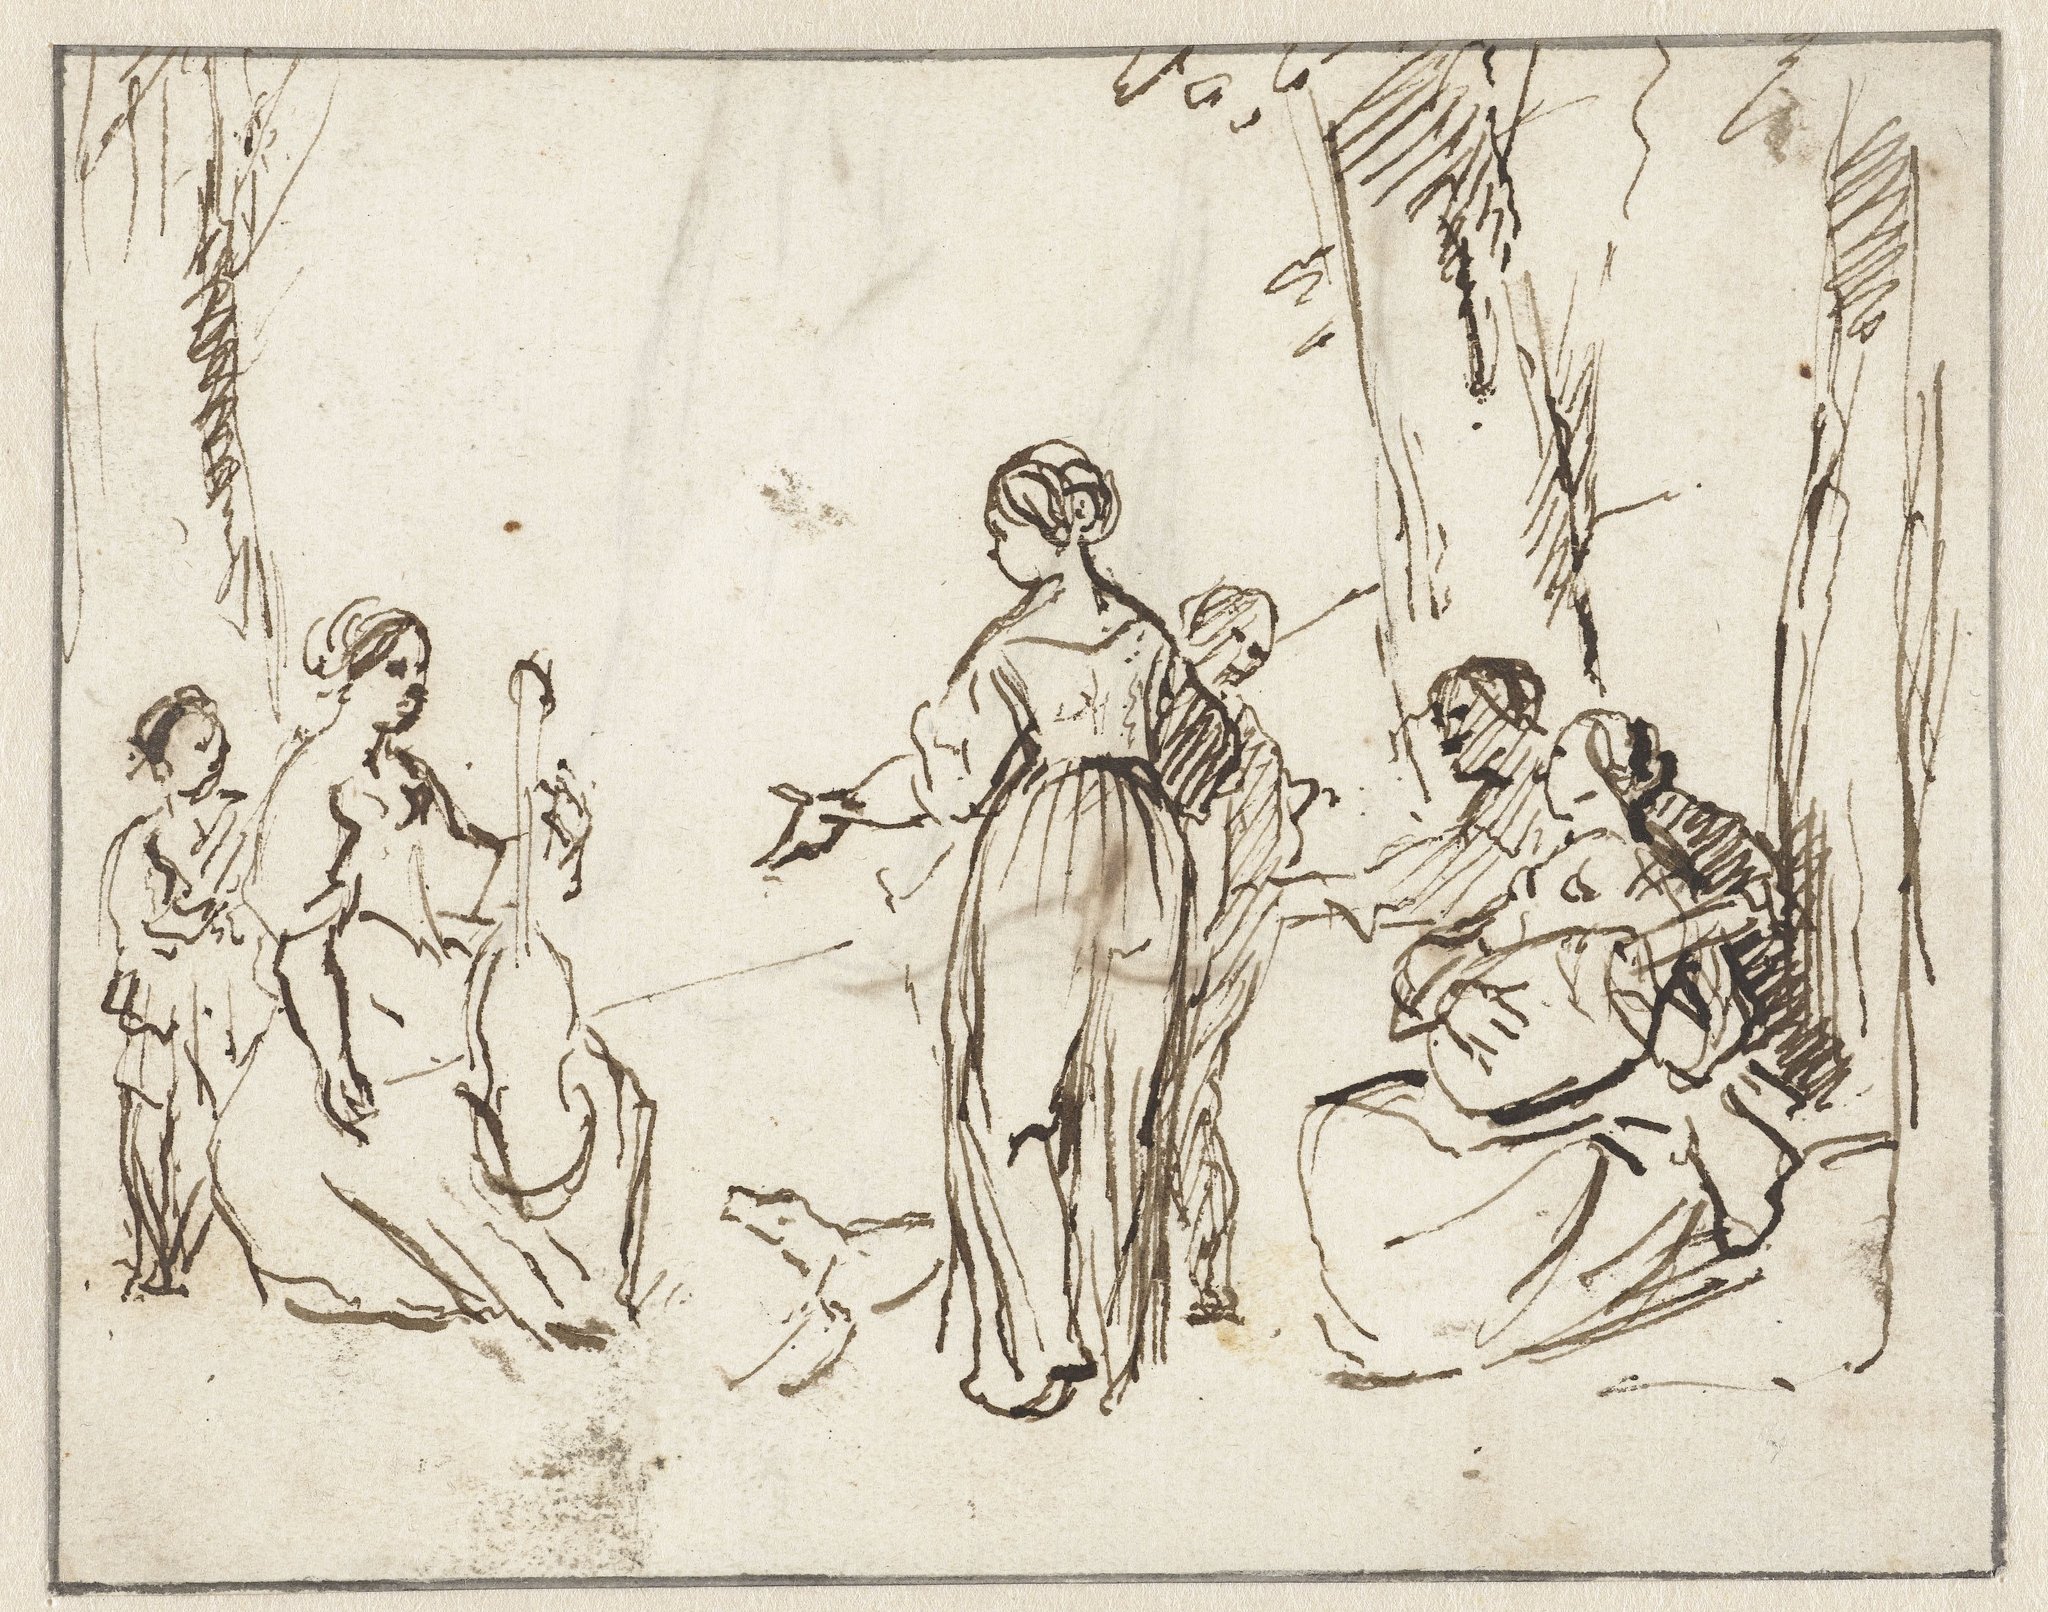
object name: drawing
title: Musicerend gezelschap in een tuin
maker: gerard pietersz. van zijl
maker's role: draughtsman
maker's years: 1607-1665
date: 1617-1665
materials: ink, paper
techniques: pen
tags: more than one musician with instrument - cc - 'concert champêtre'